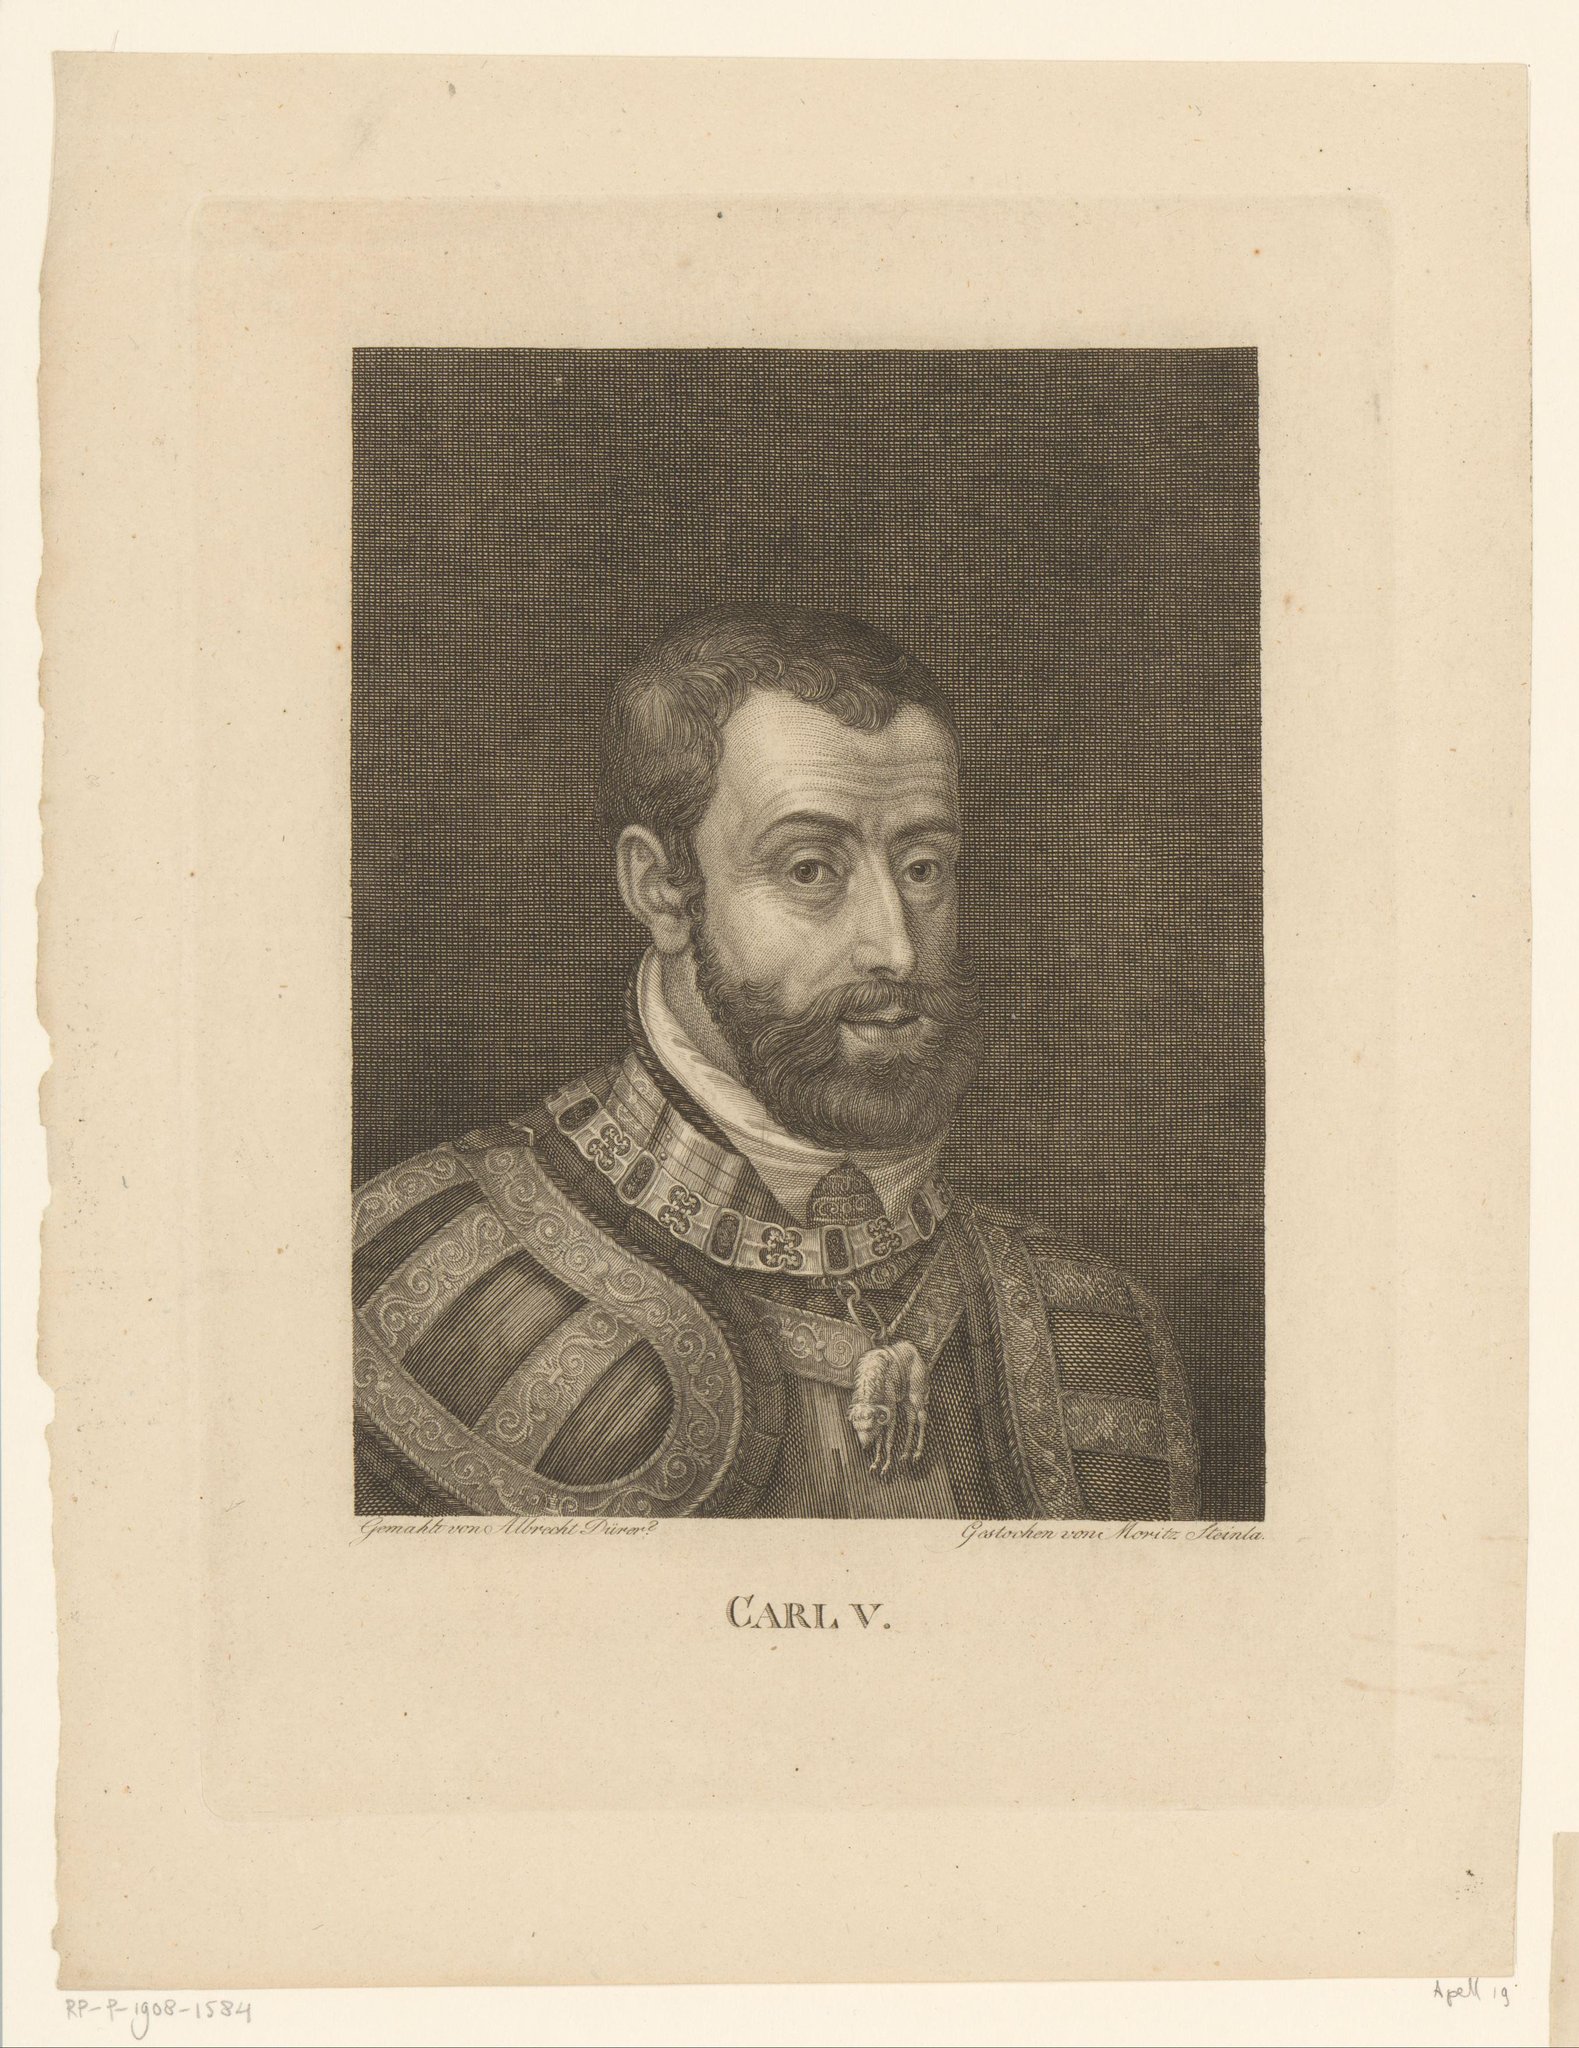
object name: print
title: Portret van keizer Karel V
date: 1818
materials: paper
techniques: engraving, etching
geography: germany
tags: ghent, charles v (holy roman emperor and king of spain), historical persons, knighthood order of the golden fleece - insignia of a knighthood order, e.g.: badge, chain (with name of order)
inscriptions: collector's mark: Lugt 2228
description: Prent gebruikt voor de publicatie: Jacobi, Johann Adolph. Eichenlaub, auf Luthers Grab gestreut im Jahre 1817. Erfurt en Gotha: Henning Buchhandlung, 1818.